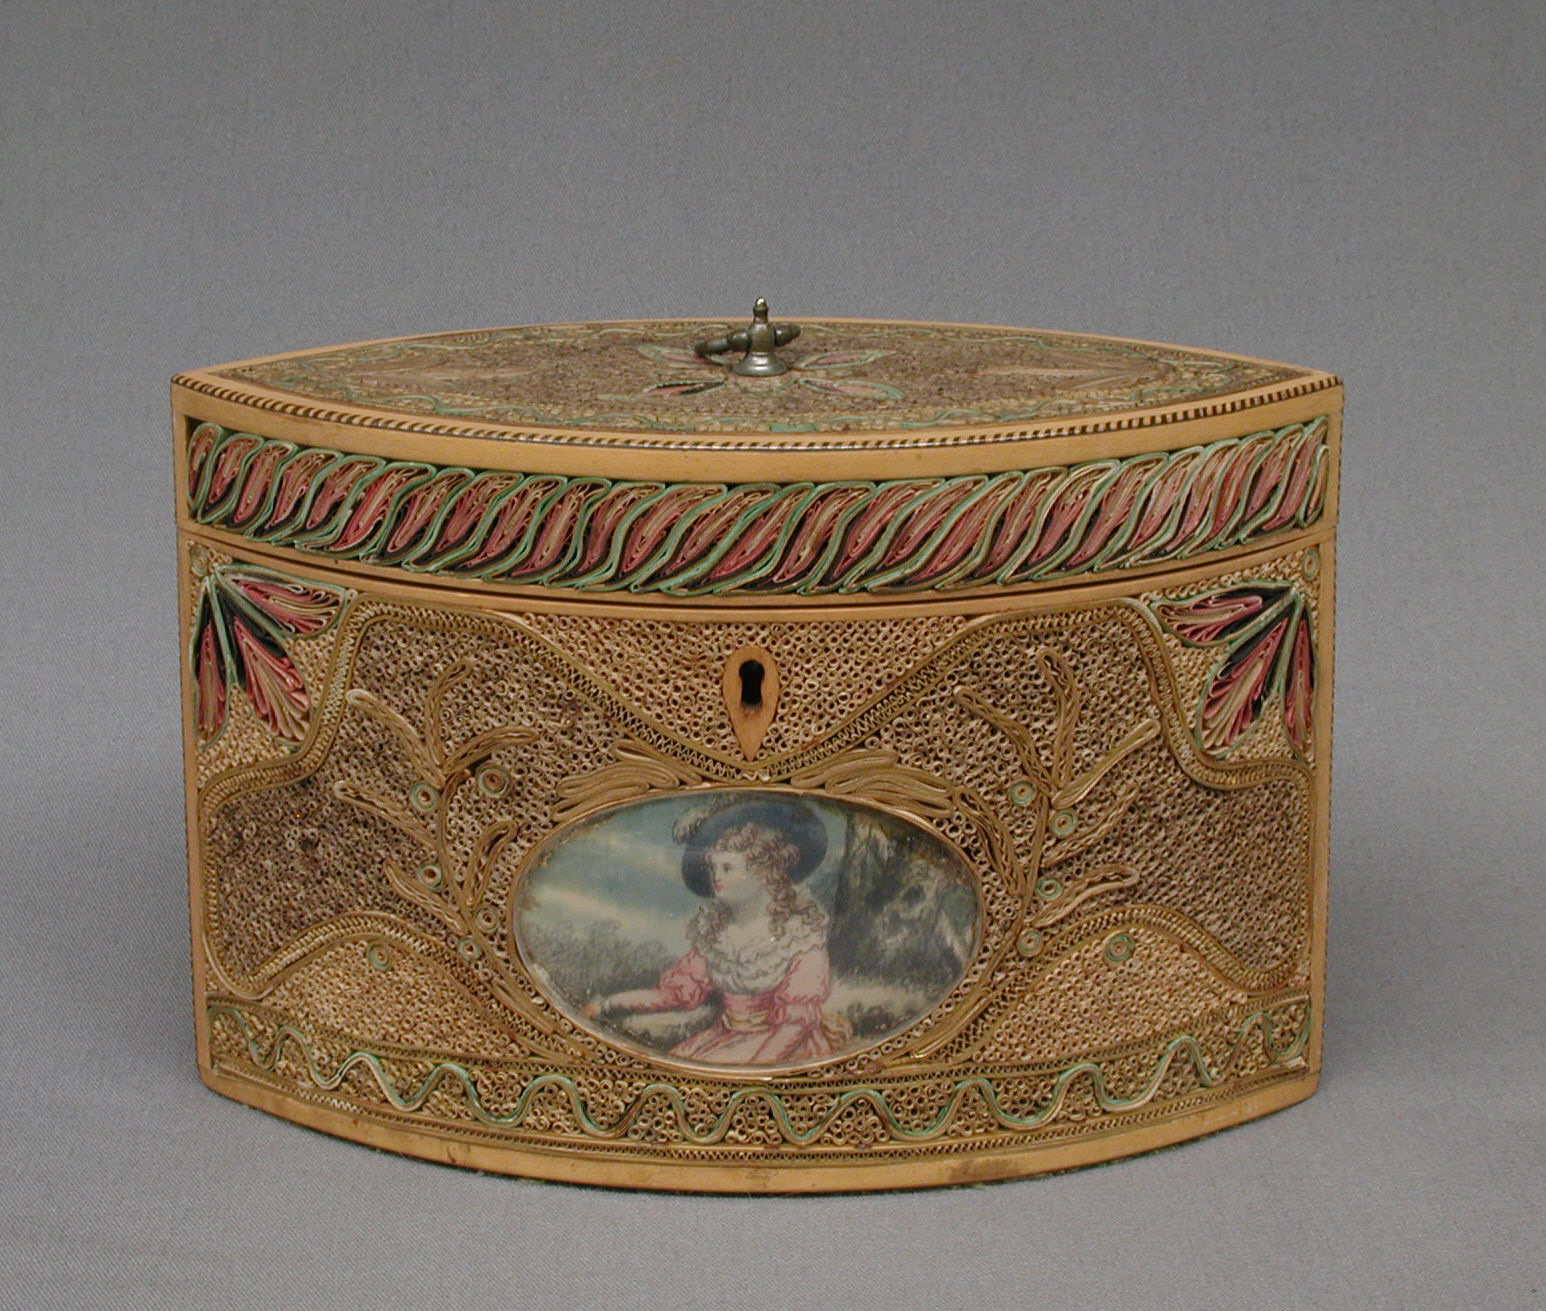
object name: tea caddy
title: Tea caddy (one of a pair)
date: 1801-1833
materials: paper, wood, silk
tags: women